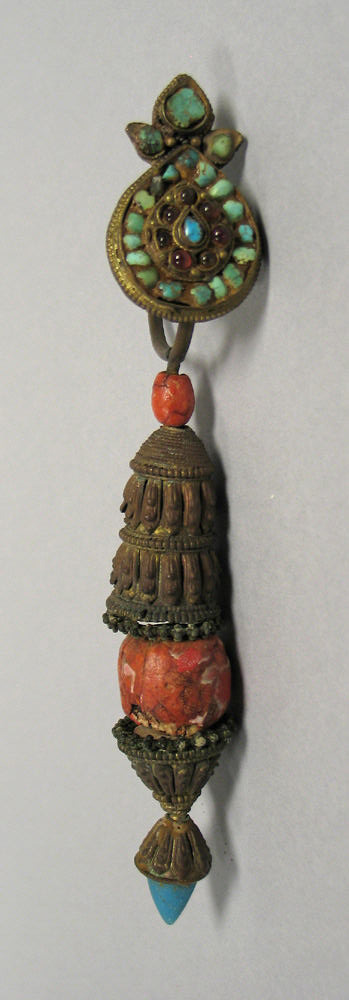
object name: earring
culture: tibet, eastern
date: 1801-1900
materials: gold, stone